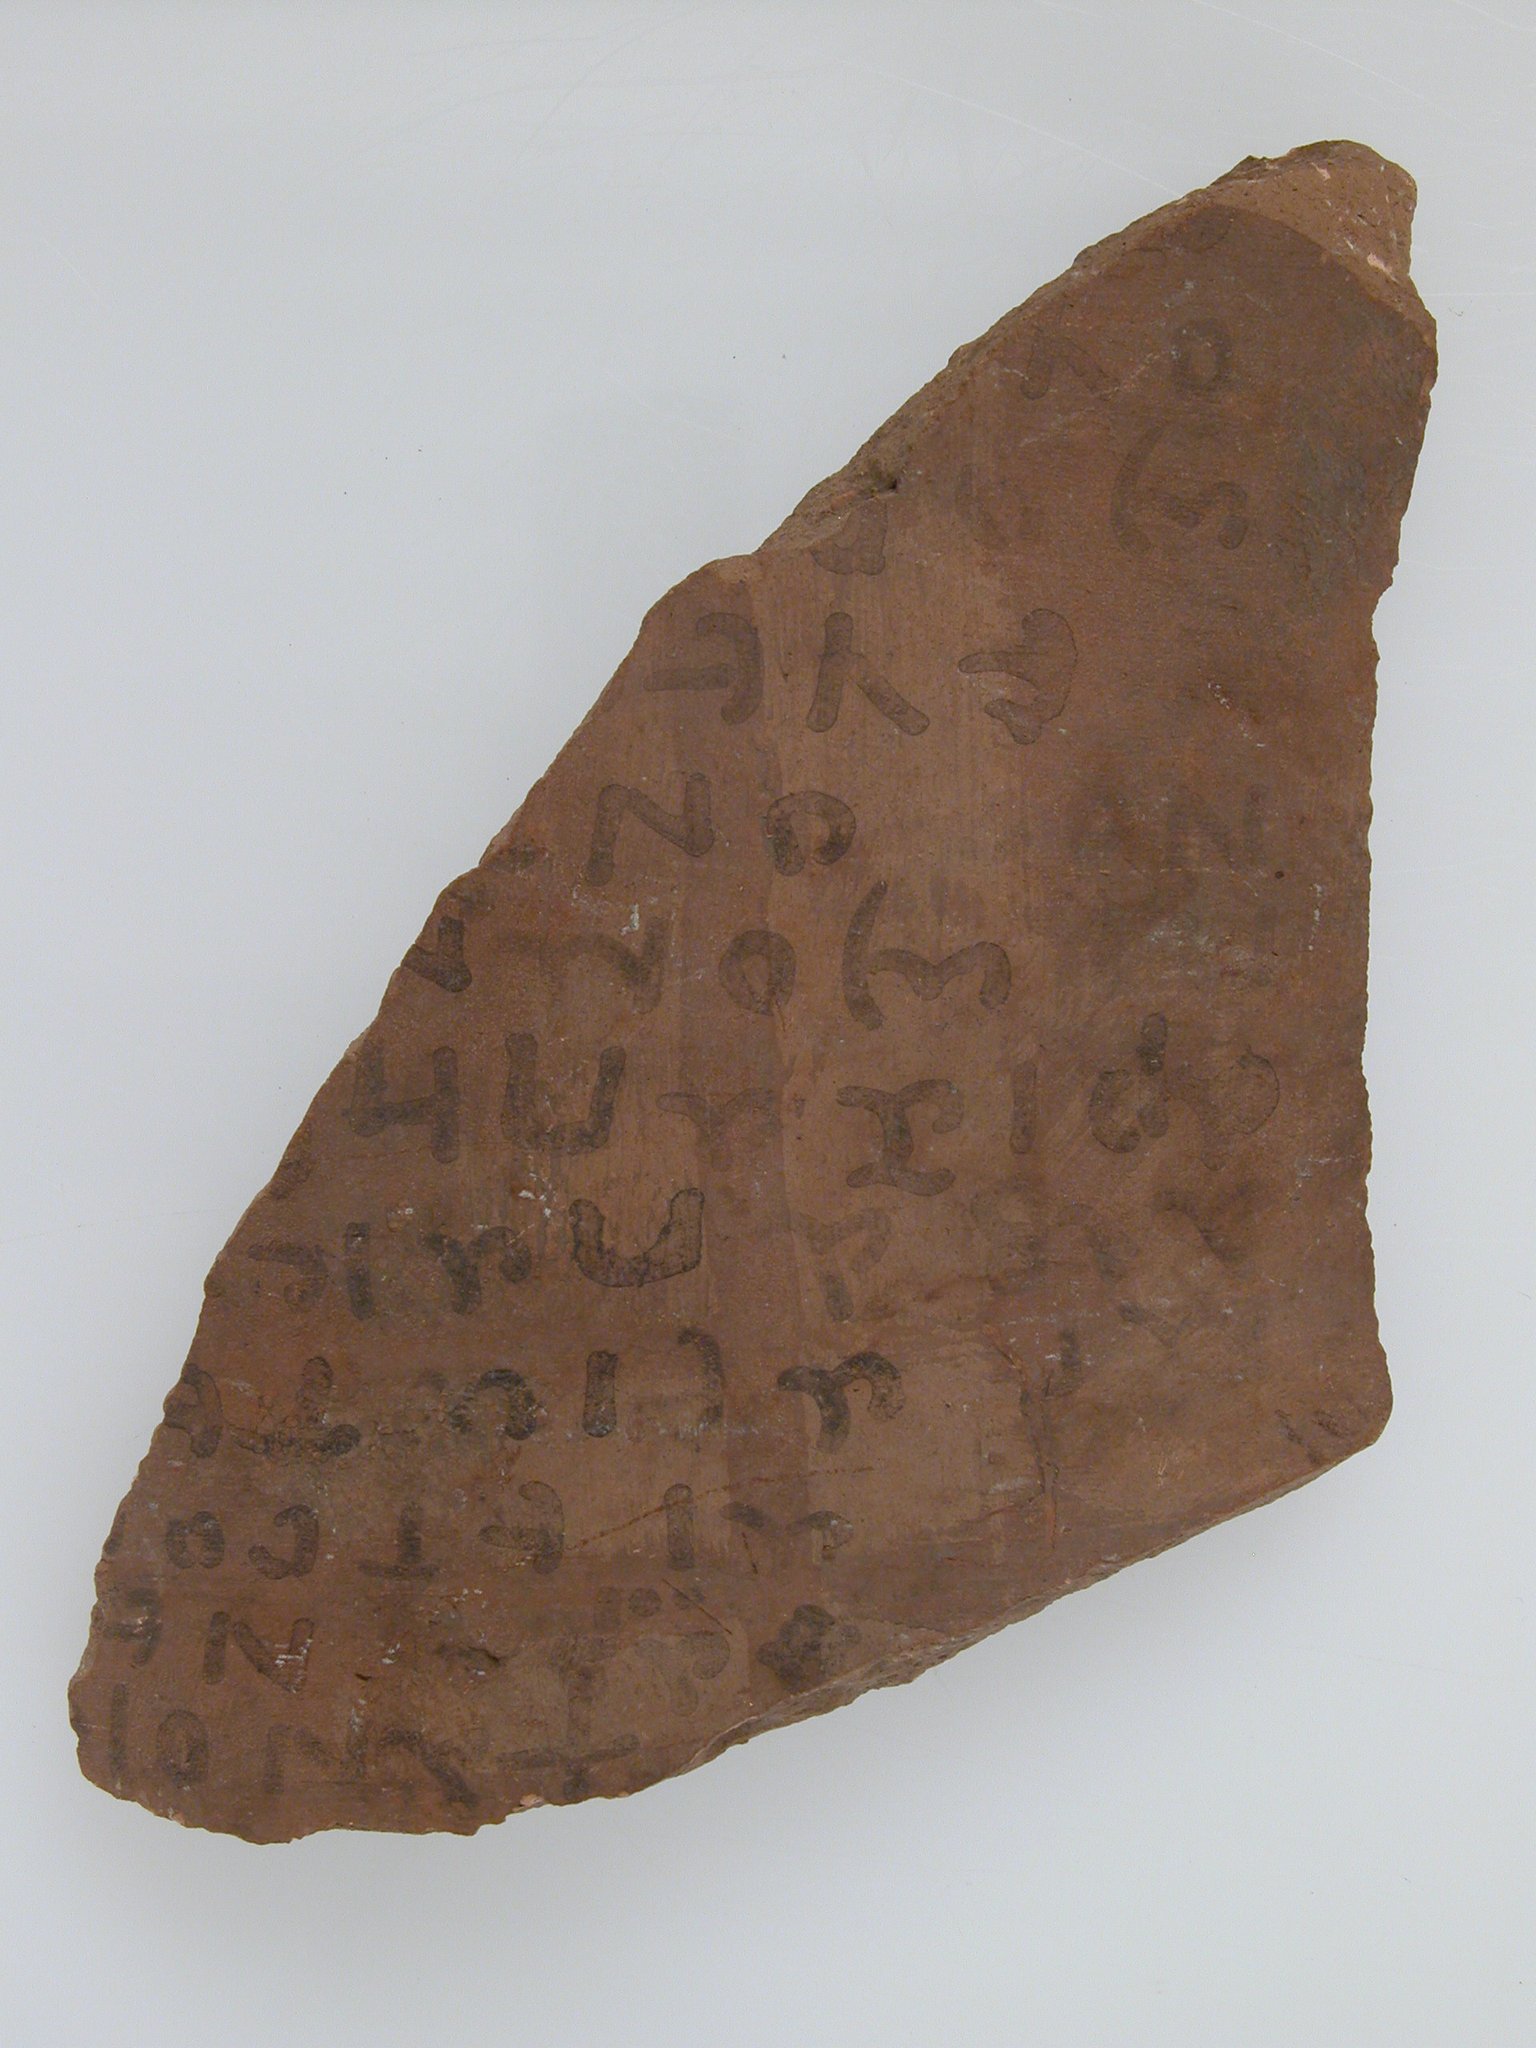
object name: ostrakon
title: Ostrakon with the Fragments of Two Letter to Apa Cyriacus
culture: coptic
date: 600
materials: ink, pottery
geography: egypt